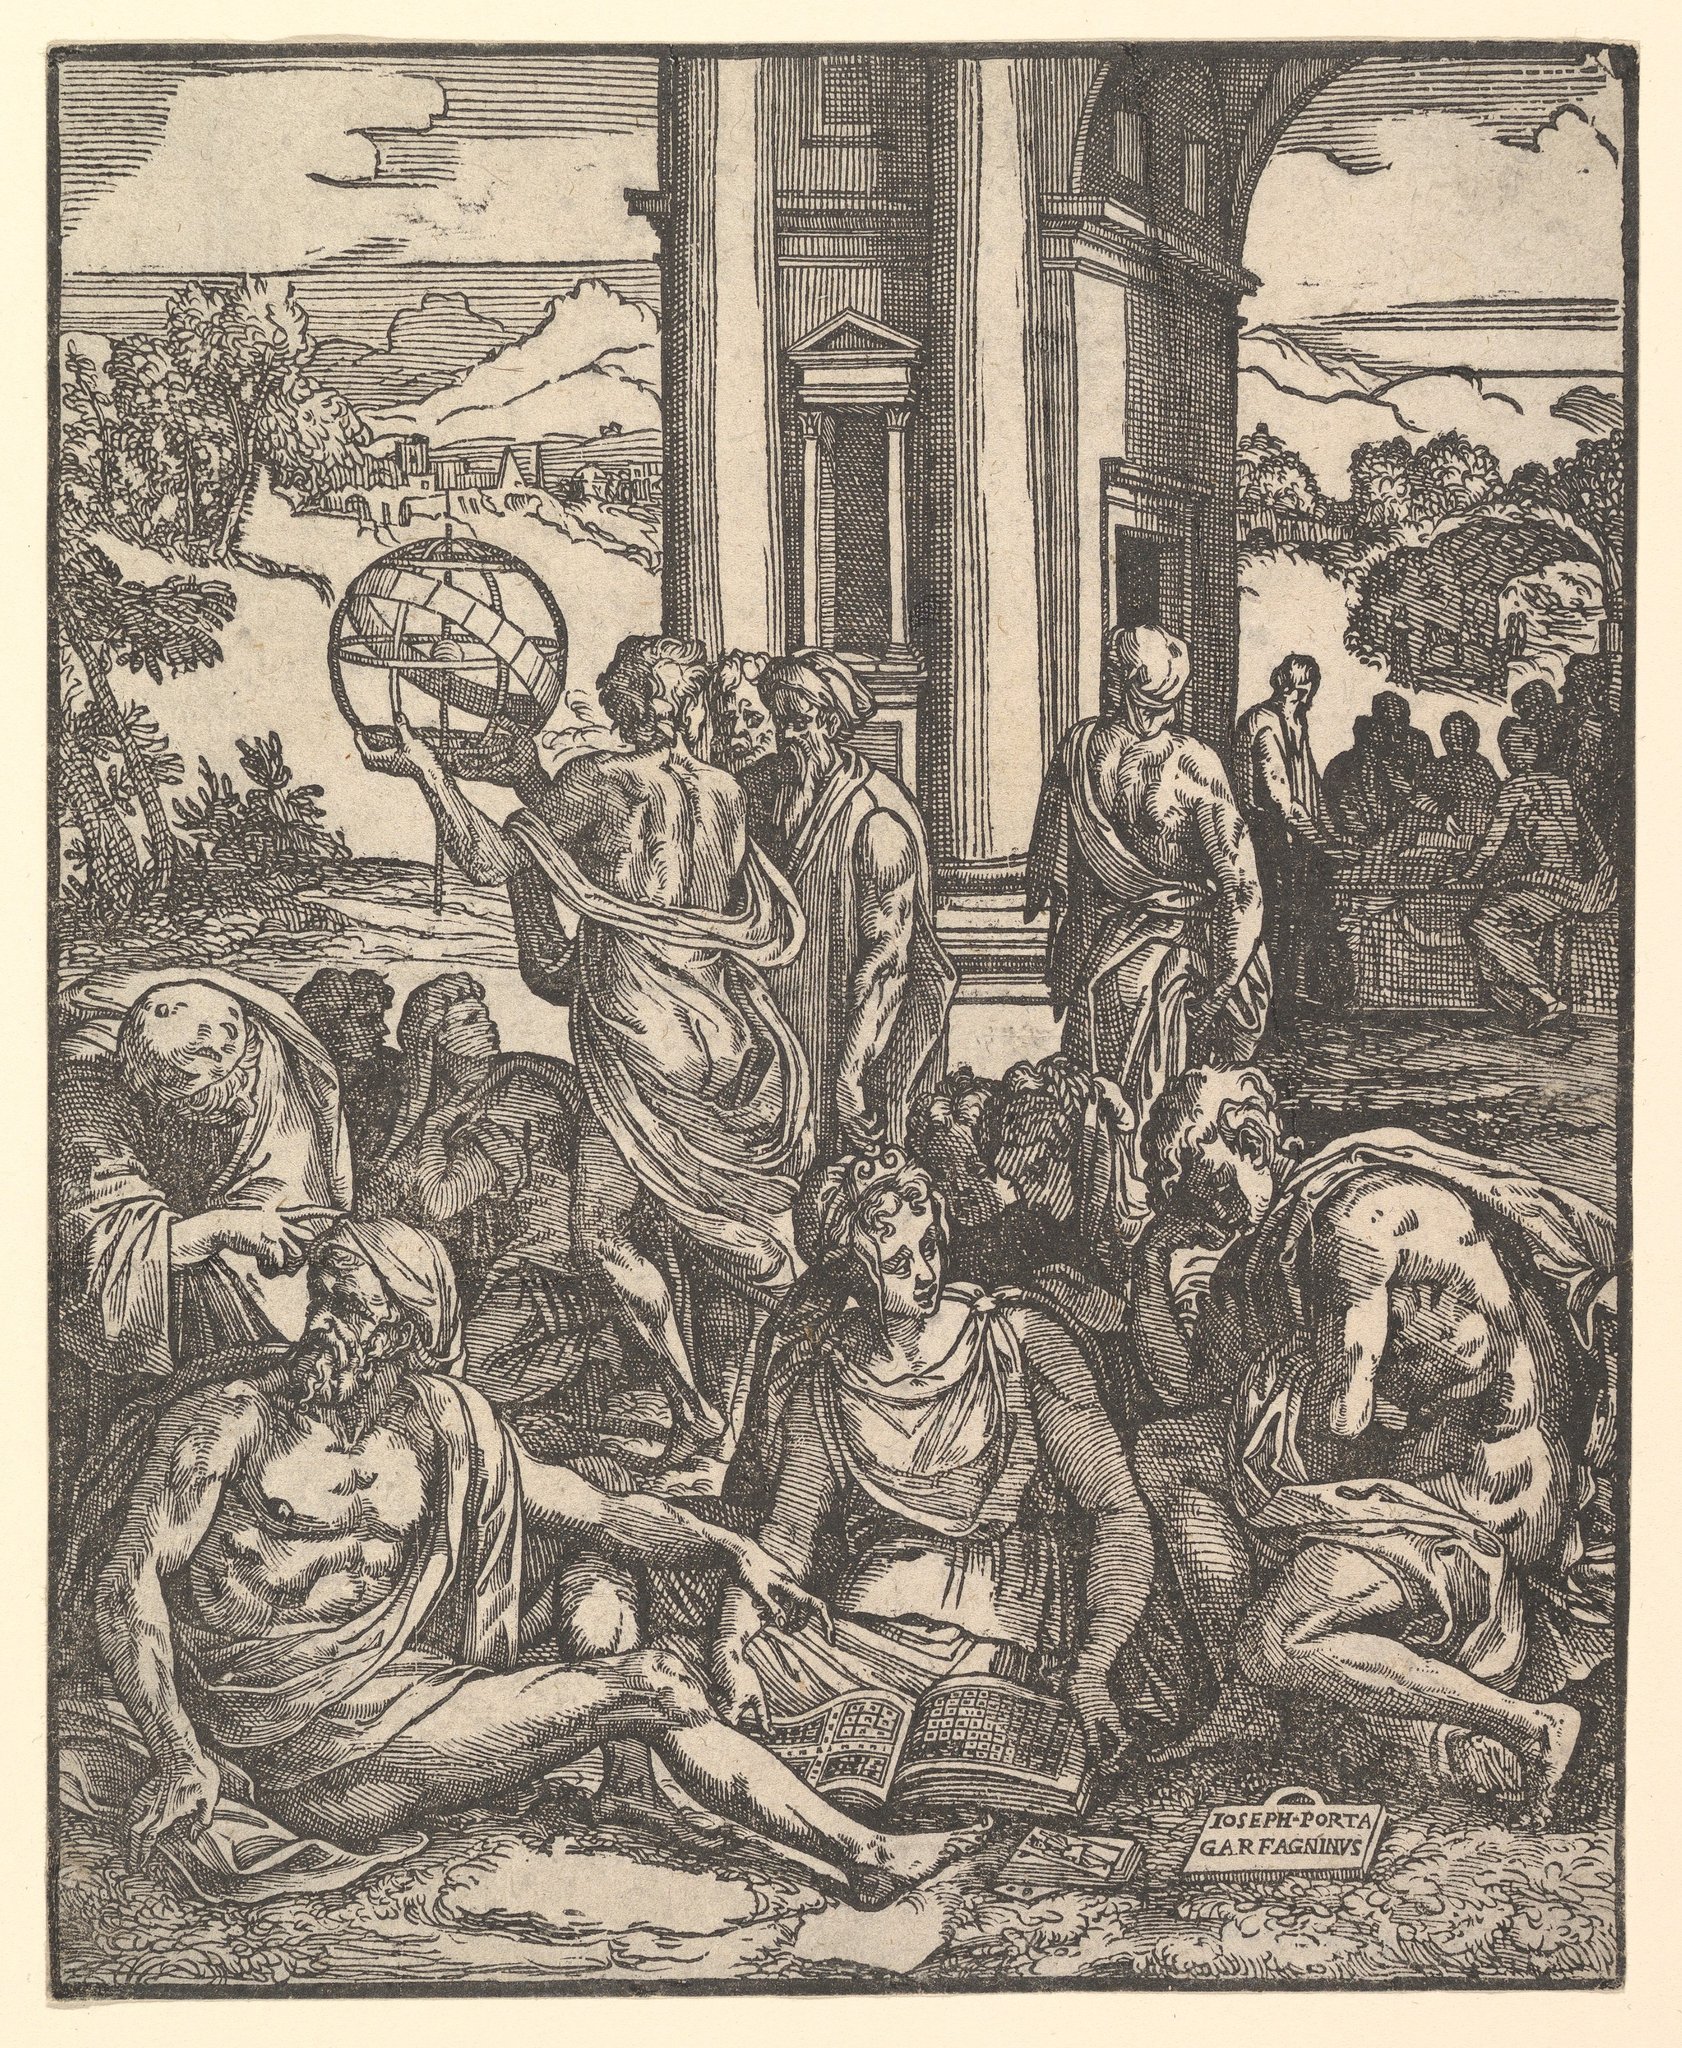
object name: print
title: Frontispiece to 'Le sorti di Francesco Marcolini da Forli intitolato Giardino di Pensieri'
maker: giuseppe salviati (giuseppe porta, called il salviati)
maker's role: artist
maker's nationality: italian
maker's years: 1515-1580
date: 1540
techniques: woodcut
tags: books,men,women,reading